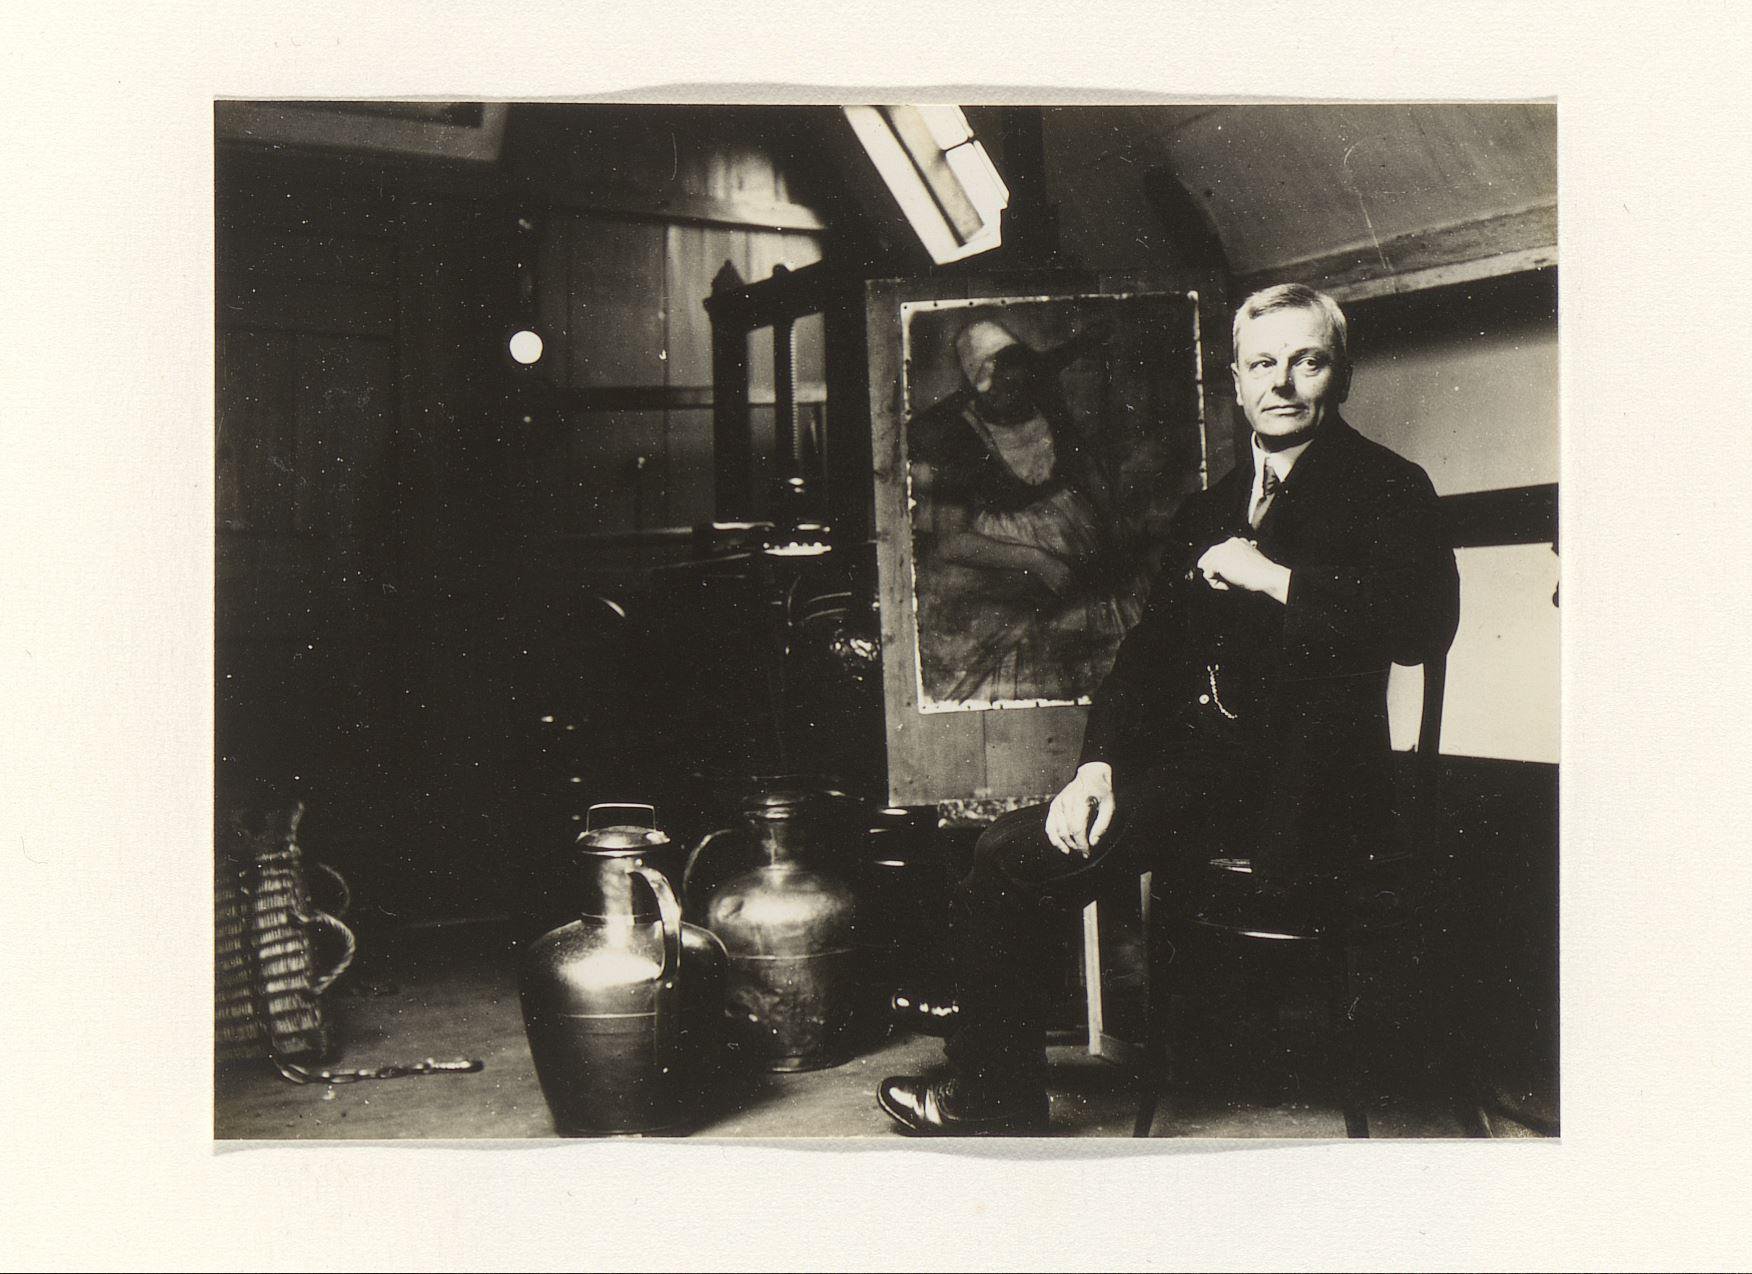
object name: photograph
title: Man in een schildersatelier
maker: george hidderley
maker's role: fotograaf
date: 1900-1910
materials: paper, photographic support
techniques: gelatin silver print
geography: volendam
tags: adult man, historical persons, workshop, studio ~ painter